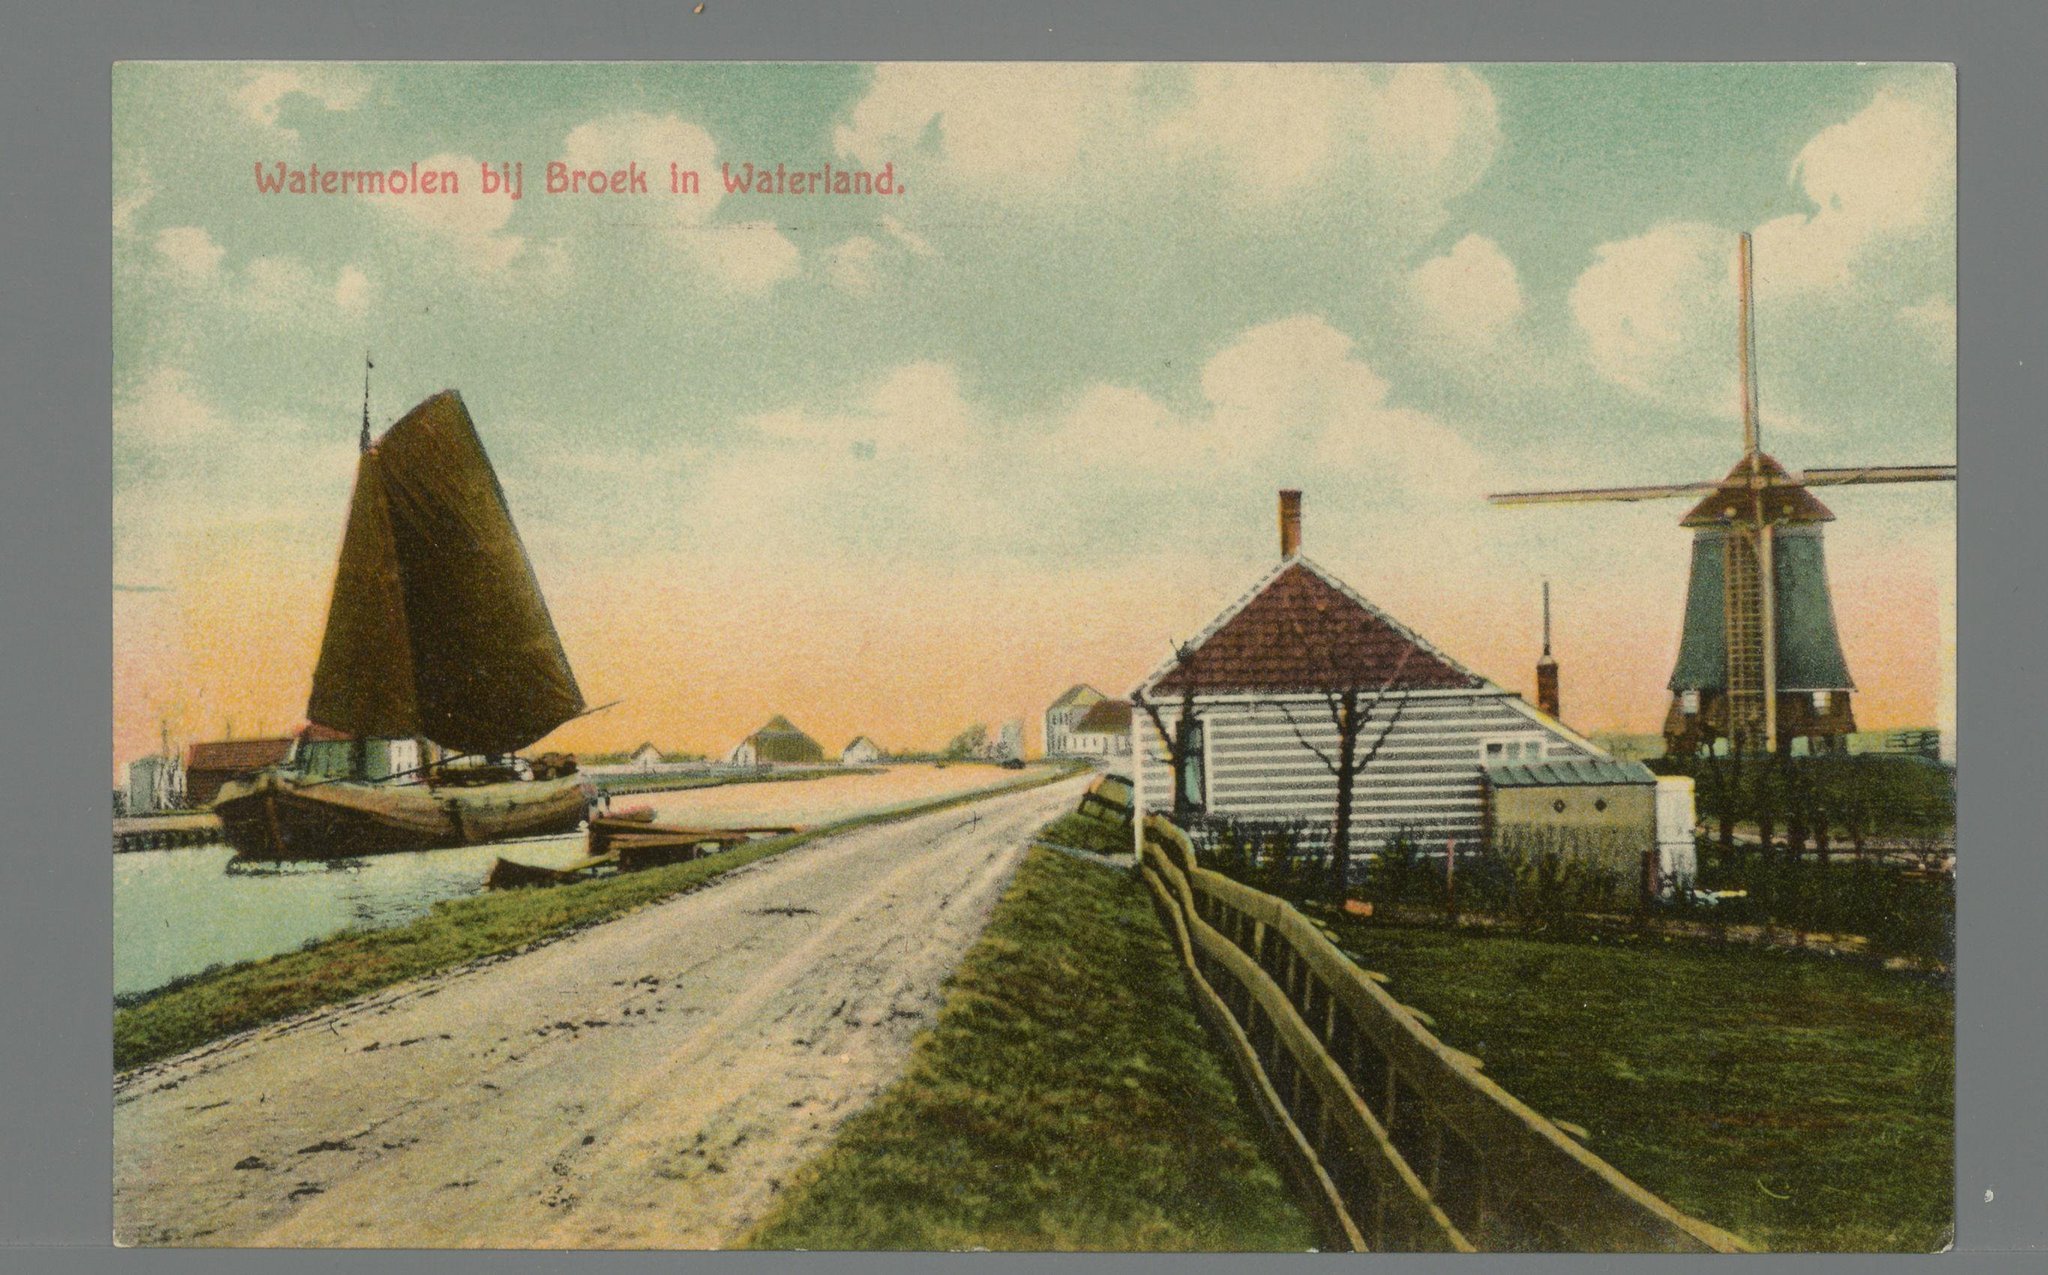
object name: ansichtkaart, prentbriefkaart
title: Watermolen bij Broek in Waterland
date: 1906-1915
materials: cardboard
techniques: photograph, lithograph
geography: broek in waterland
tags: sailing-ship, sailing-boat, watermill in landscape